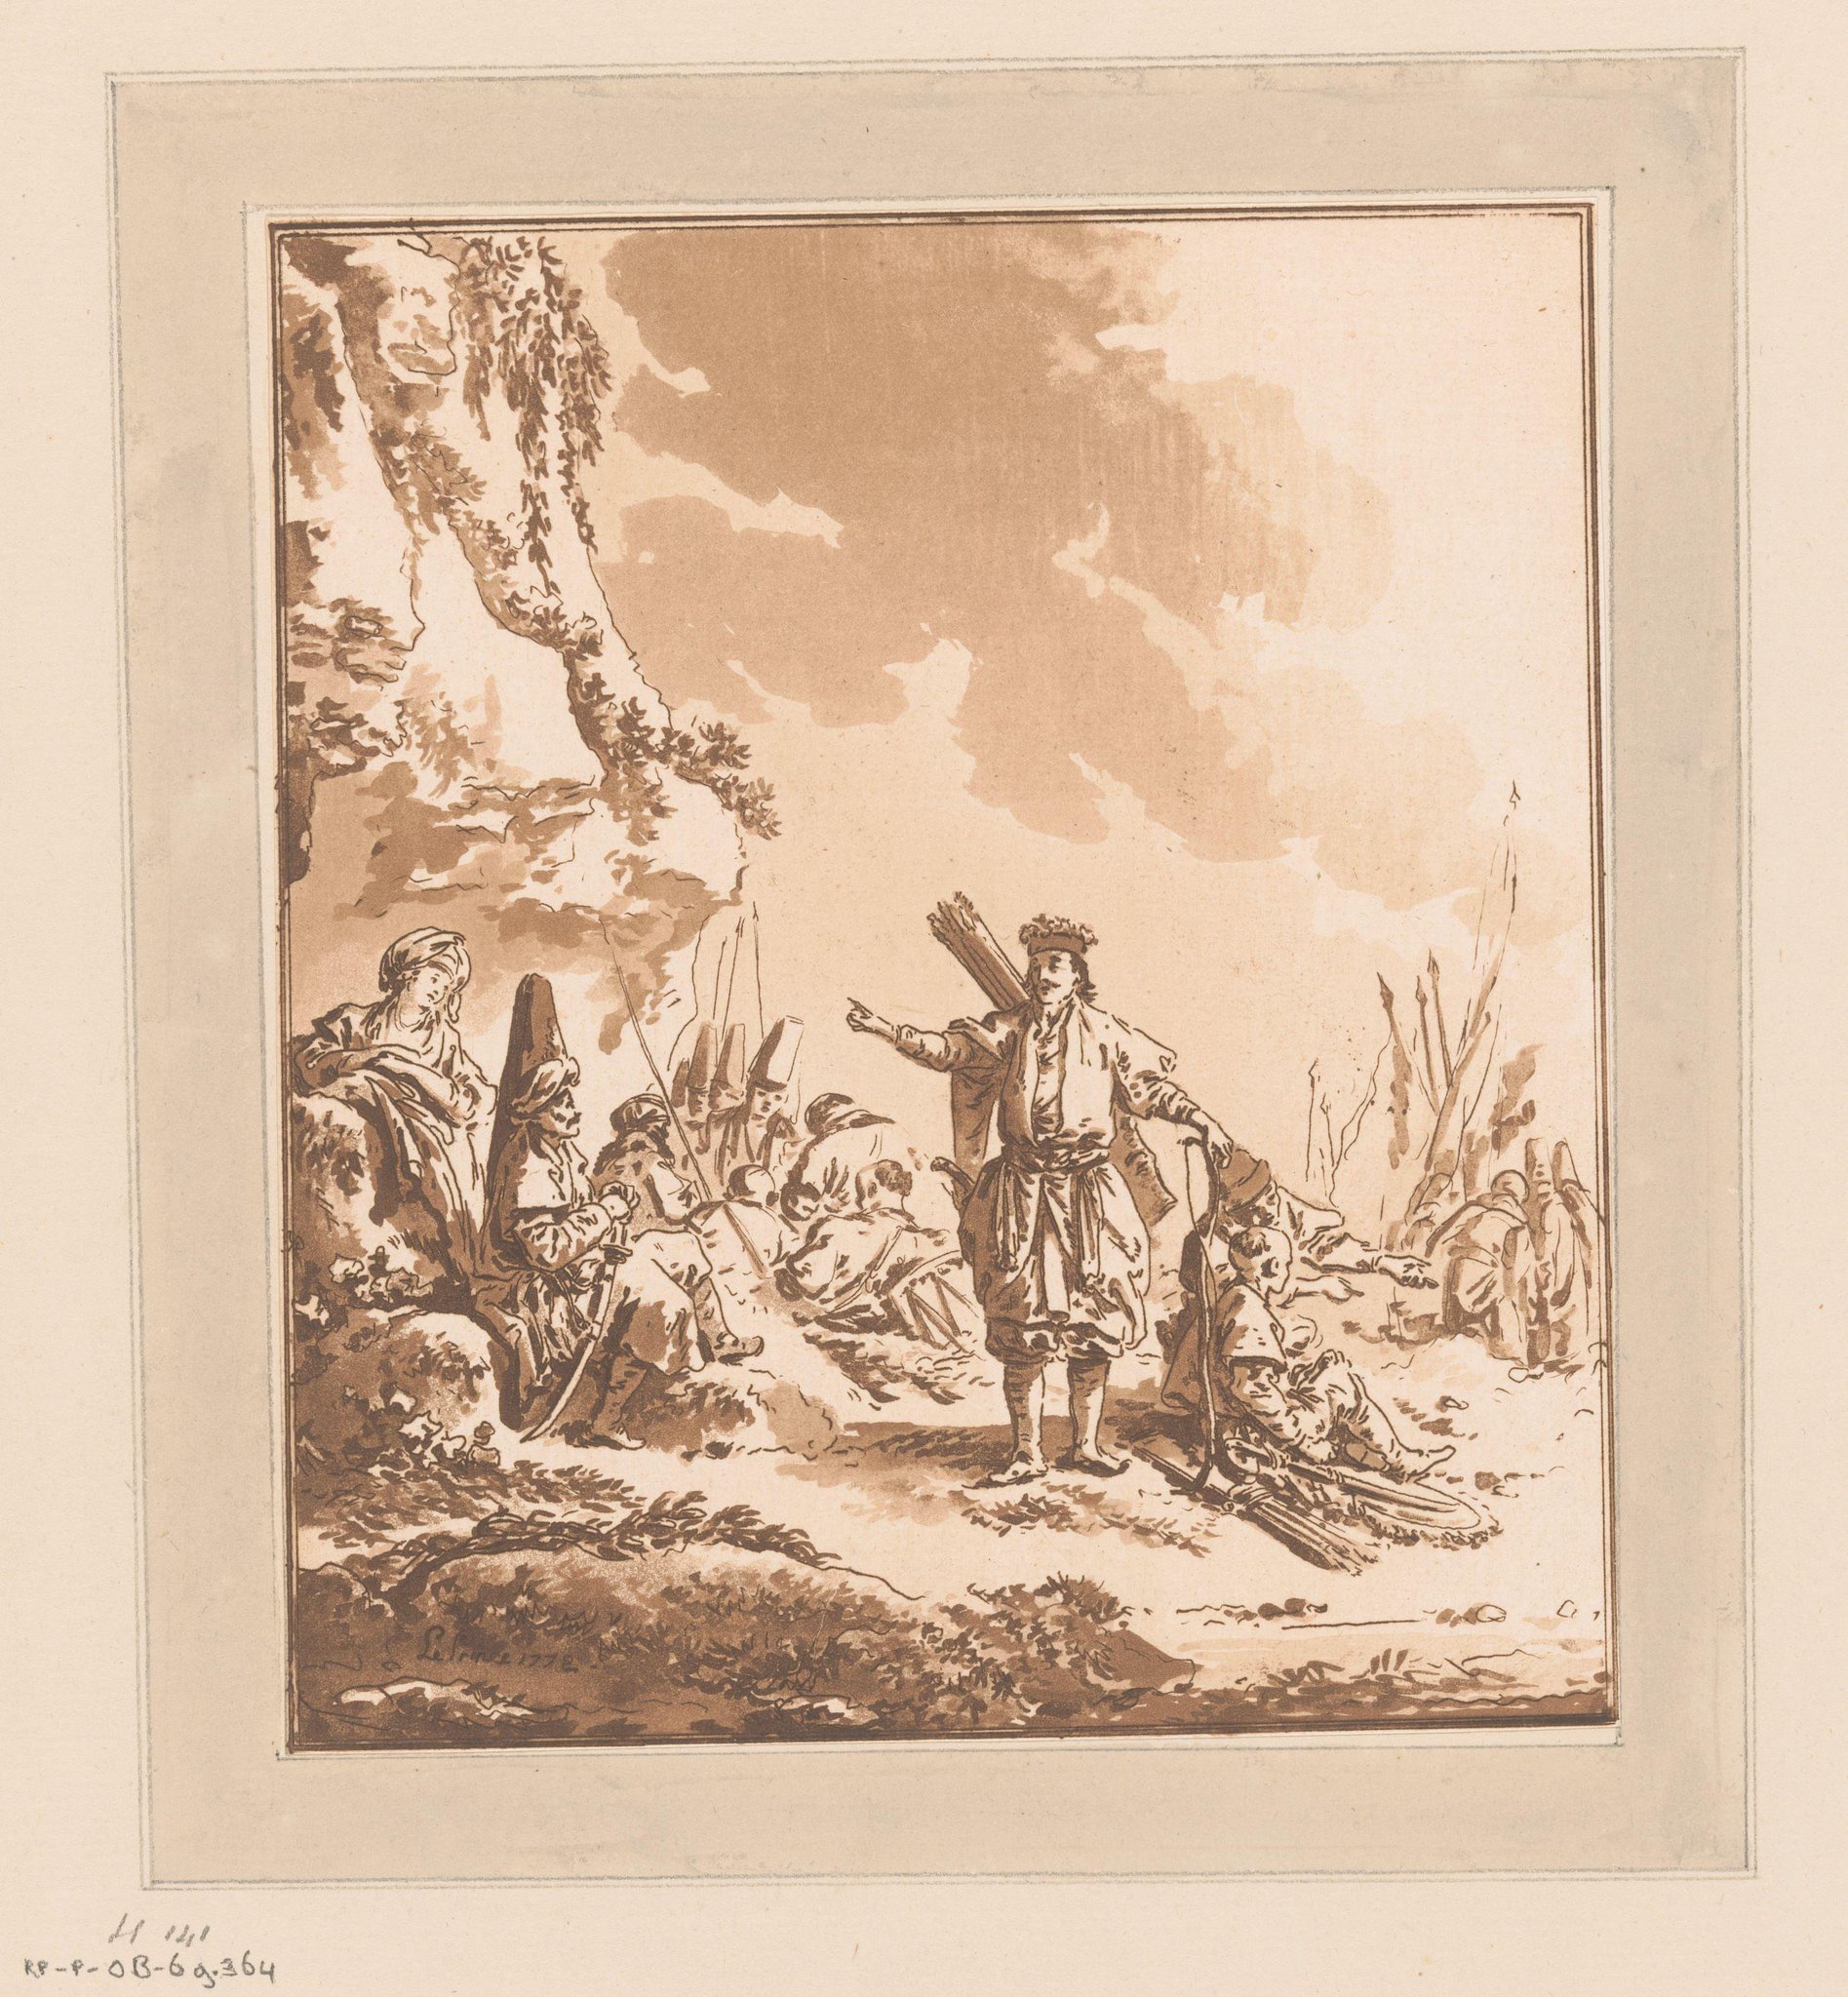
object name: print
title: Rustende Kalmukken bij een rots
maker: jean baptist leprince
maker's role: draughtsman, print maker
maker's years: 1734-1781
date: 1772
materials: paper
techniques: aquatint, etching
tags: the soldier; the soldier's life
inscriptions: date